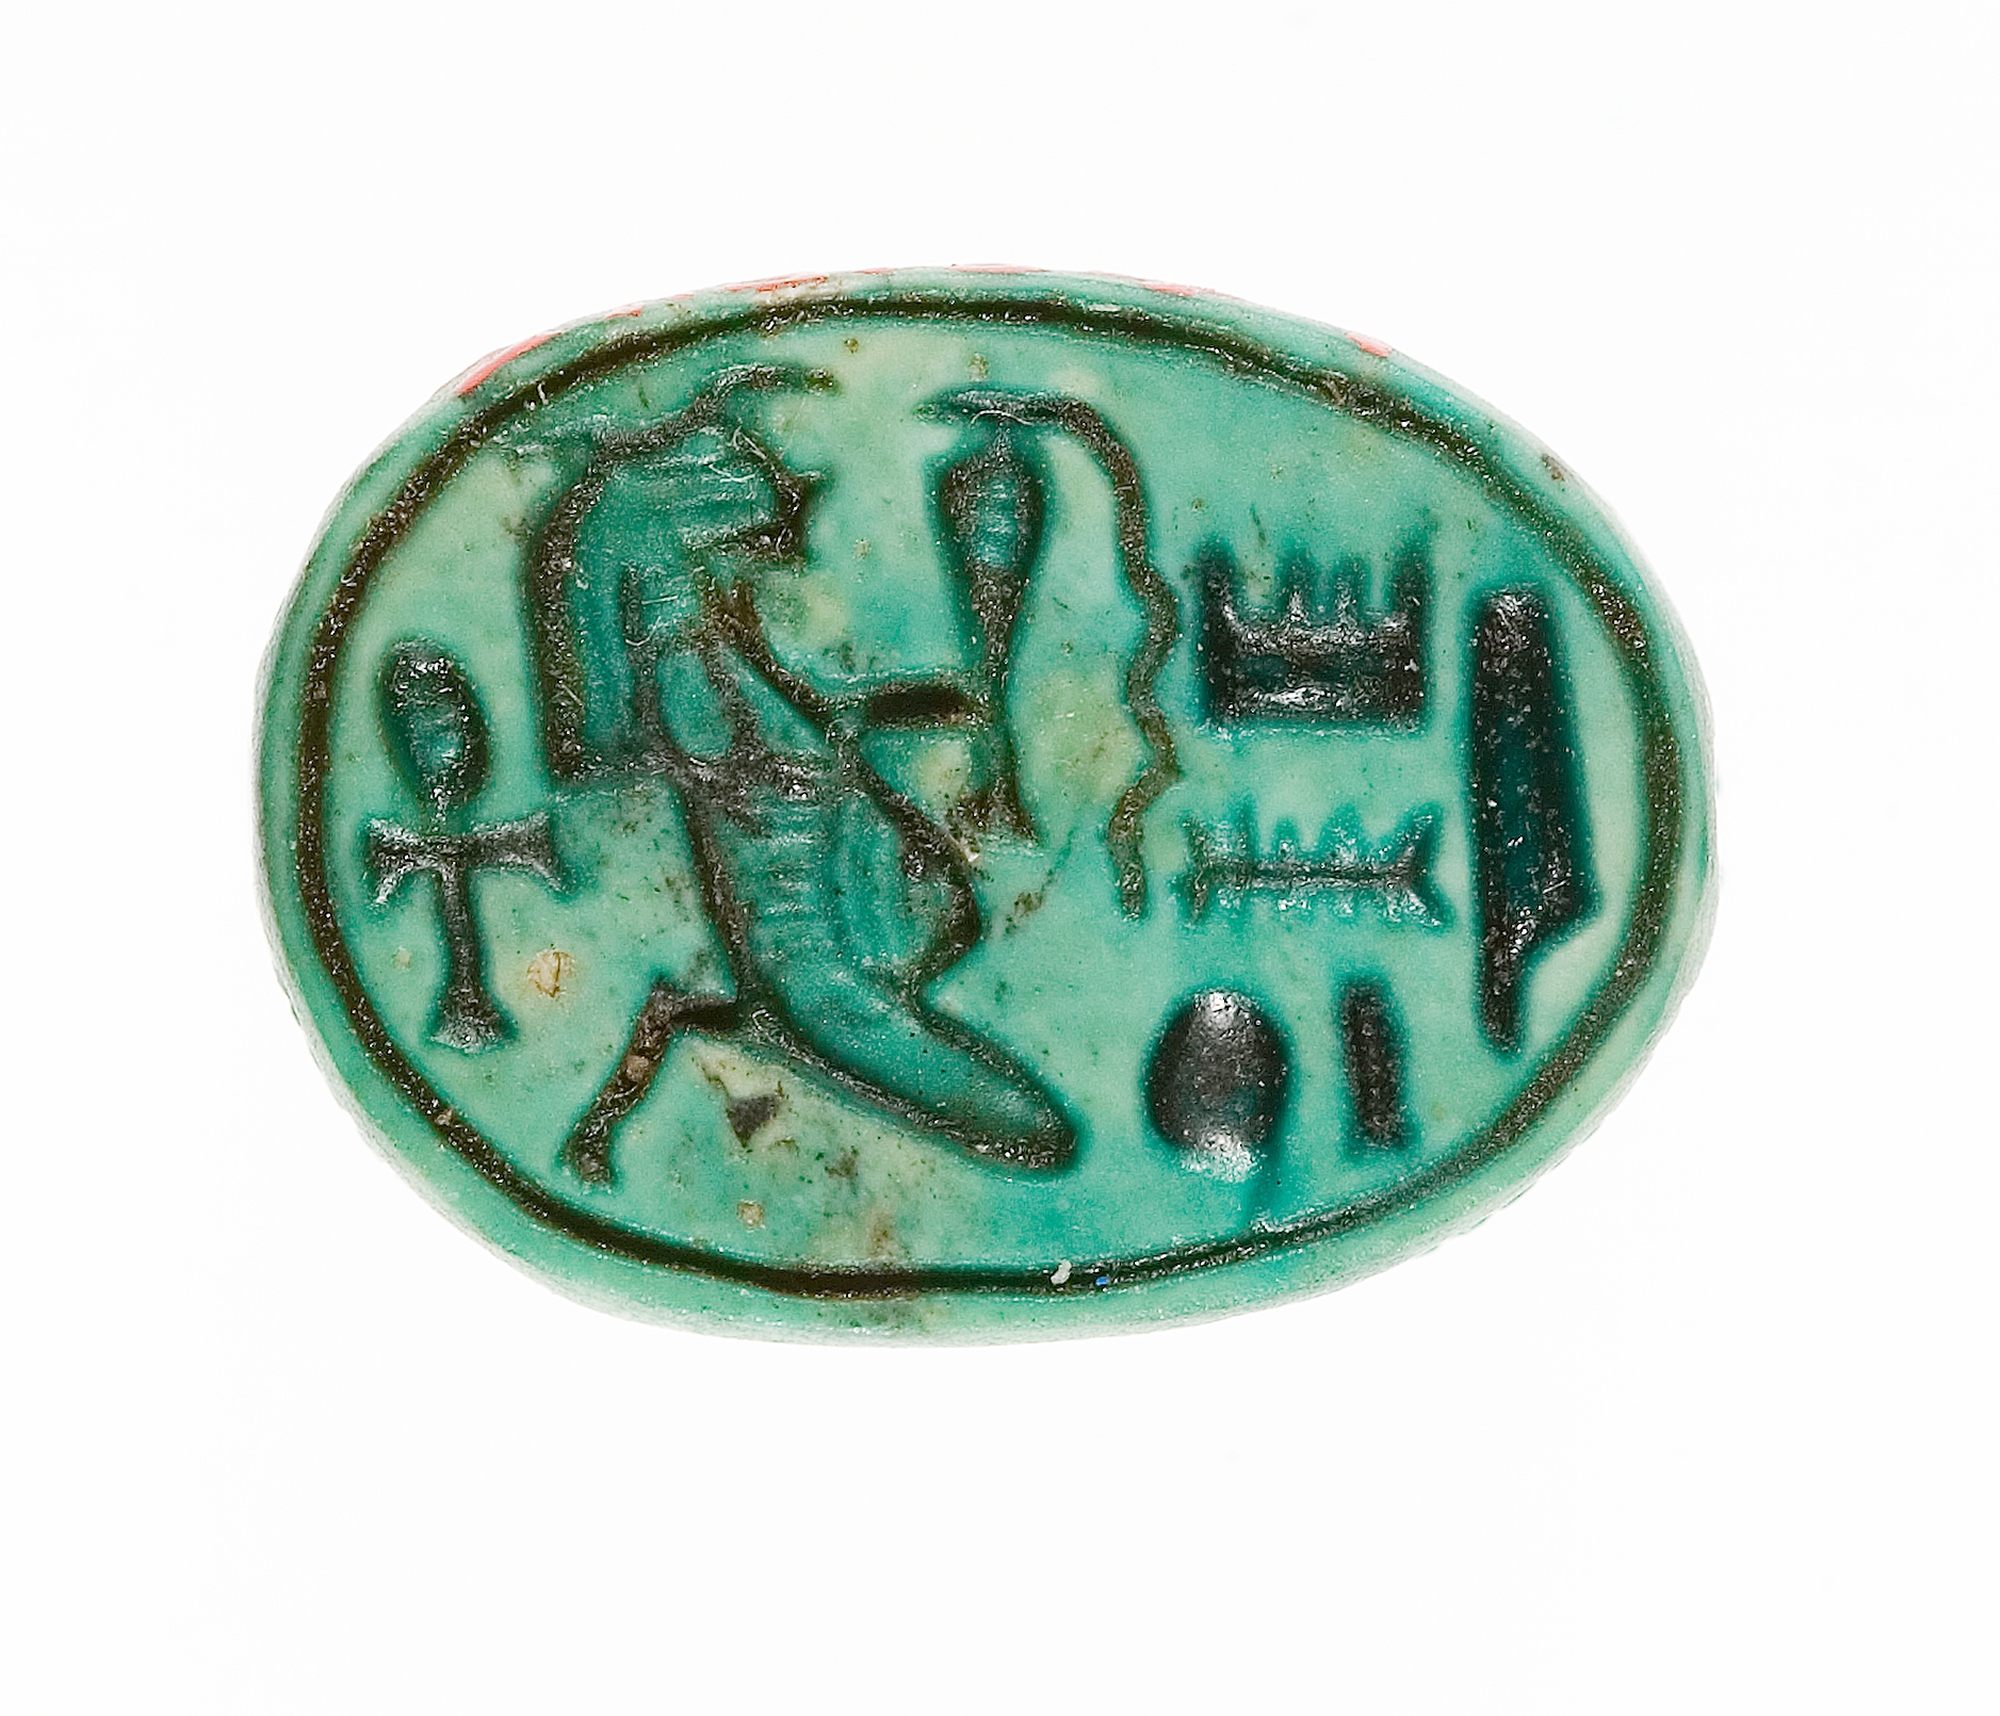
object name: scarab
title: Scarab Inscribed with the Name of the God Amun-Re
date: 1479-1458 BCE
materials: stone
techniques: glazing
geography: egypt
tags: amun,scarabs